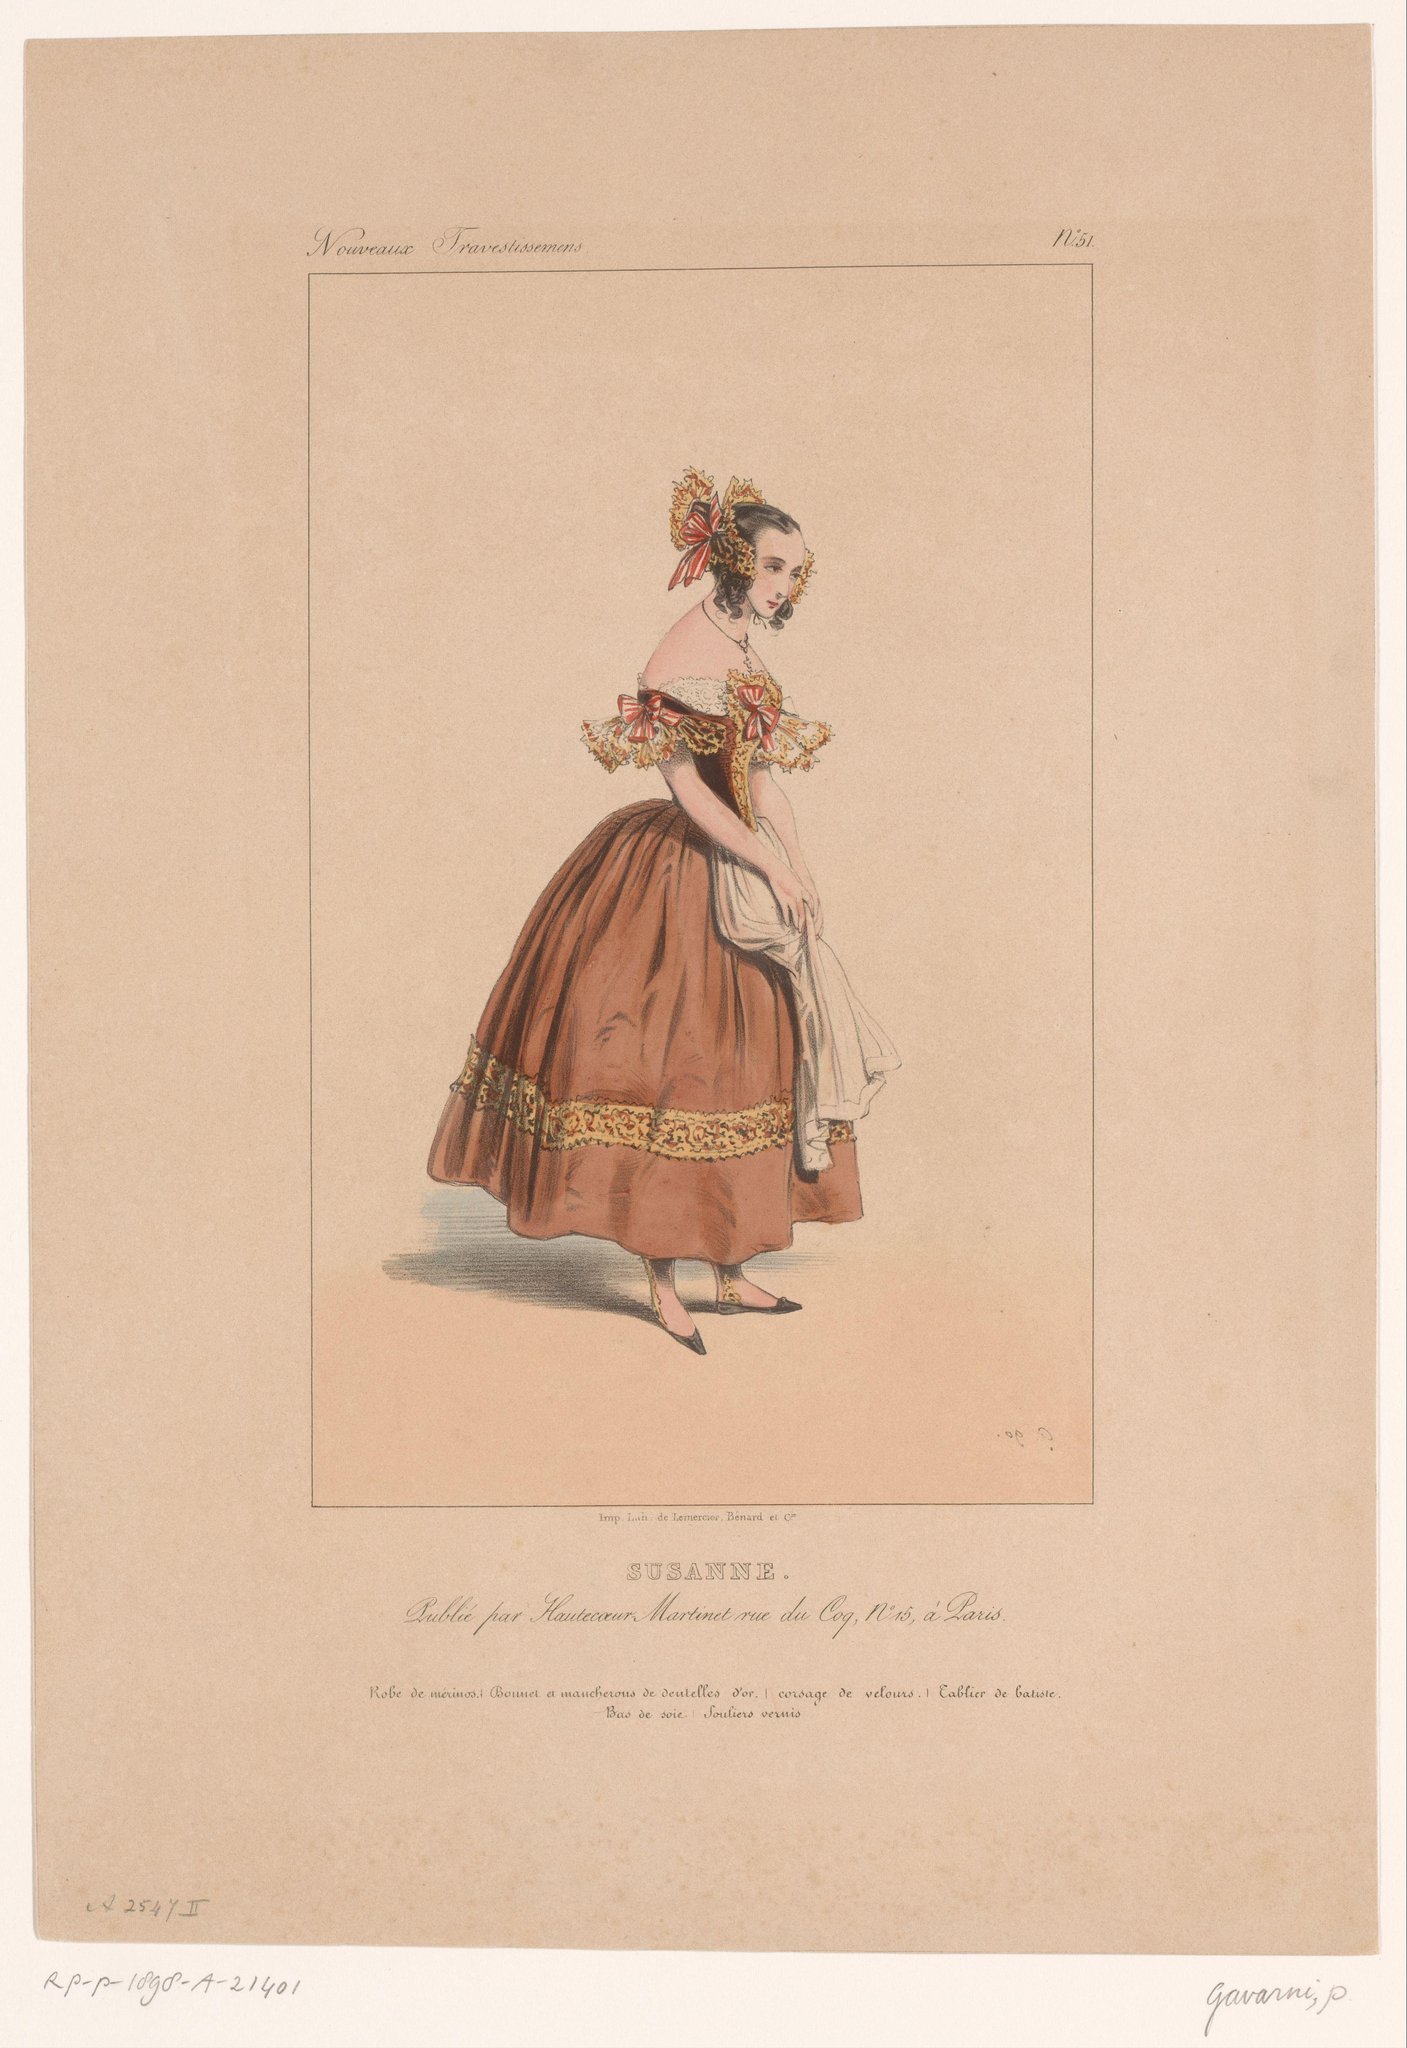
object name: print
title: Feestkostuums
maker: paul gavarni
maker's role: draughtsman, print maker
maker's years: 1804-1866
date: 1814-1866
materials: paper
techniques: hand coloring, lithograph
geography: paris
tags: party clothes, festive attire, fashion plates, disguise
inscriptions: collector's mark: Lugt 964